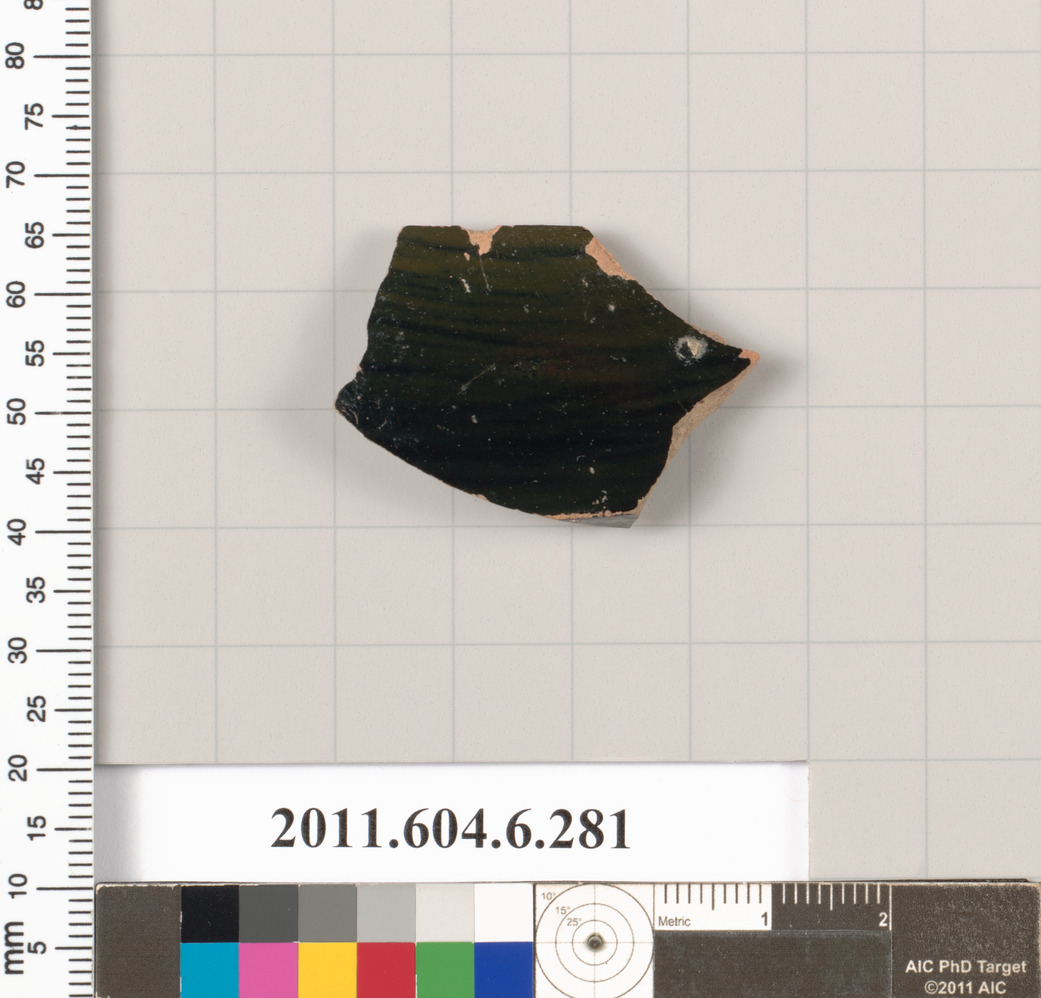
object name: undetermined open shape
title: Terracotta fragment of an open shape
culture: greek, attic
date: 600-301 BCE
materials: terracotta